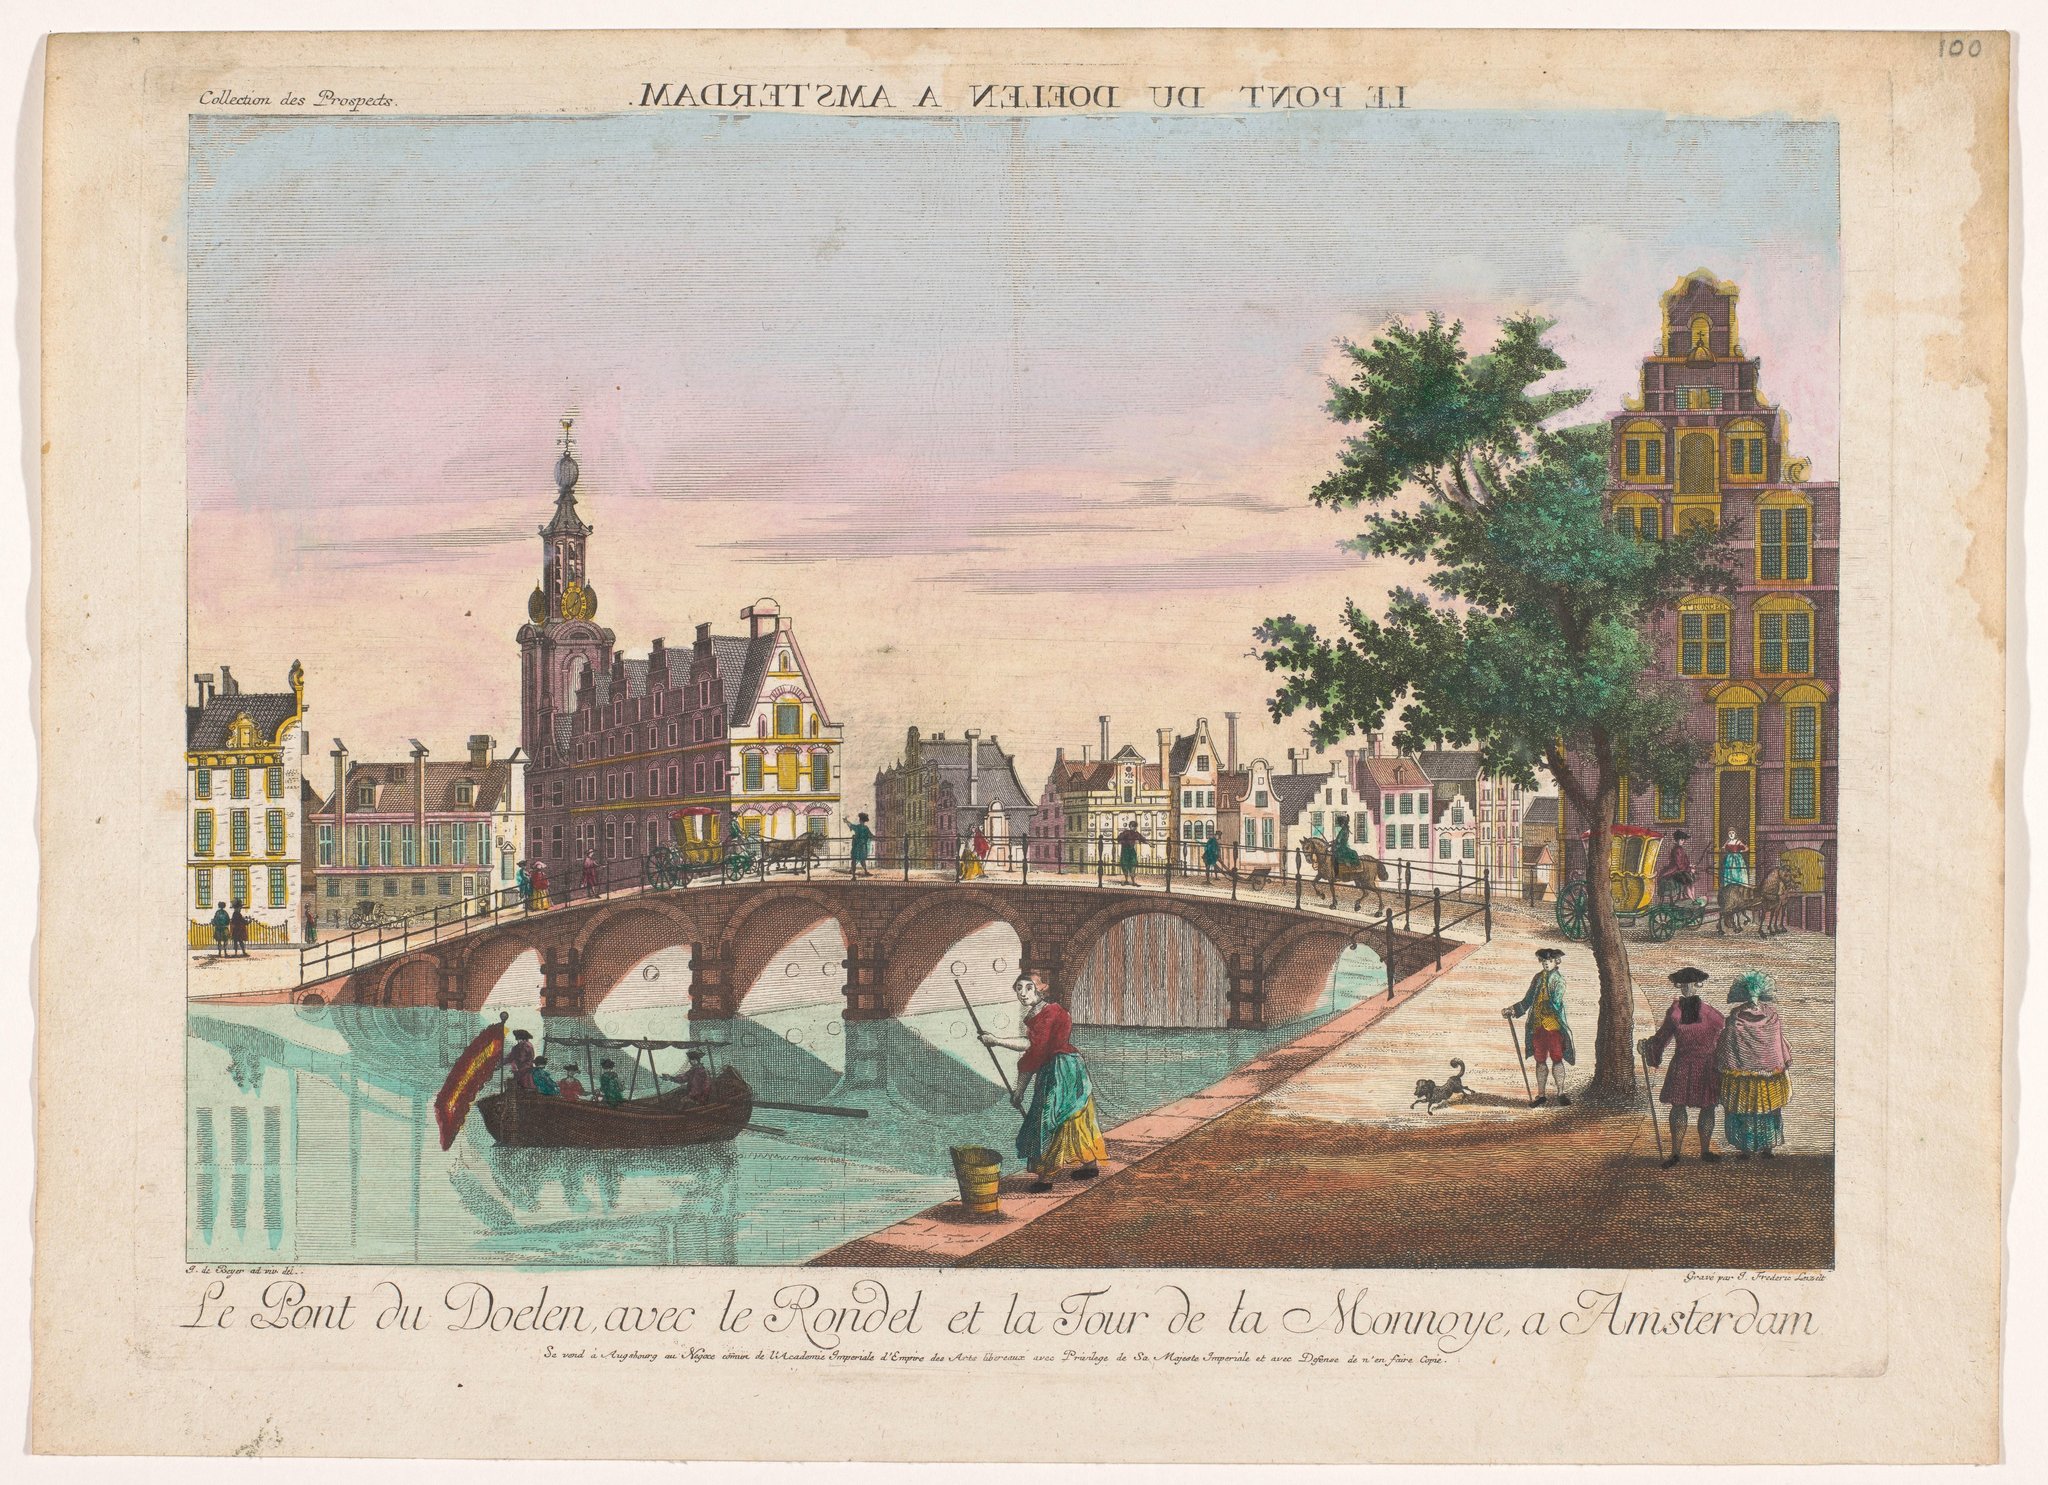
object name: print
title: Le Pont du Doelen a Amsterdam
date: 1755-1779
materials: paper, watercolor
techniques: brush, etching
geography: augsburg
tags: bridge in city across river, canal, etc. (+ city(-scape) with figures, staffage), tower, clock tower ~ monumental adornment, rowing-boat, canoe, etc.